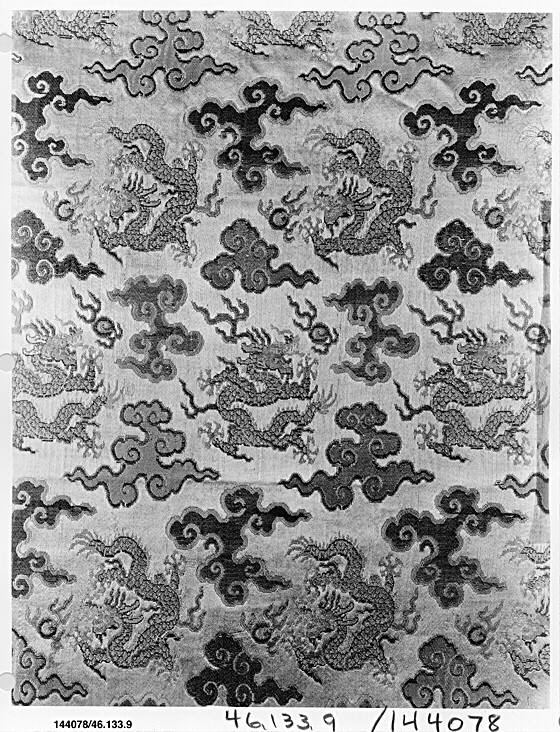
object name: piece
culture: chinese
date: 1701-1800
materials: metal thread, silk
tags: dragons